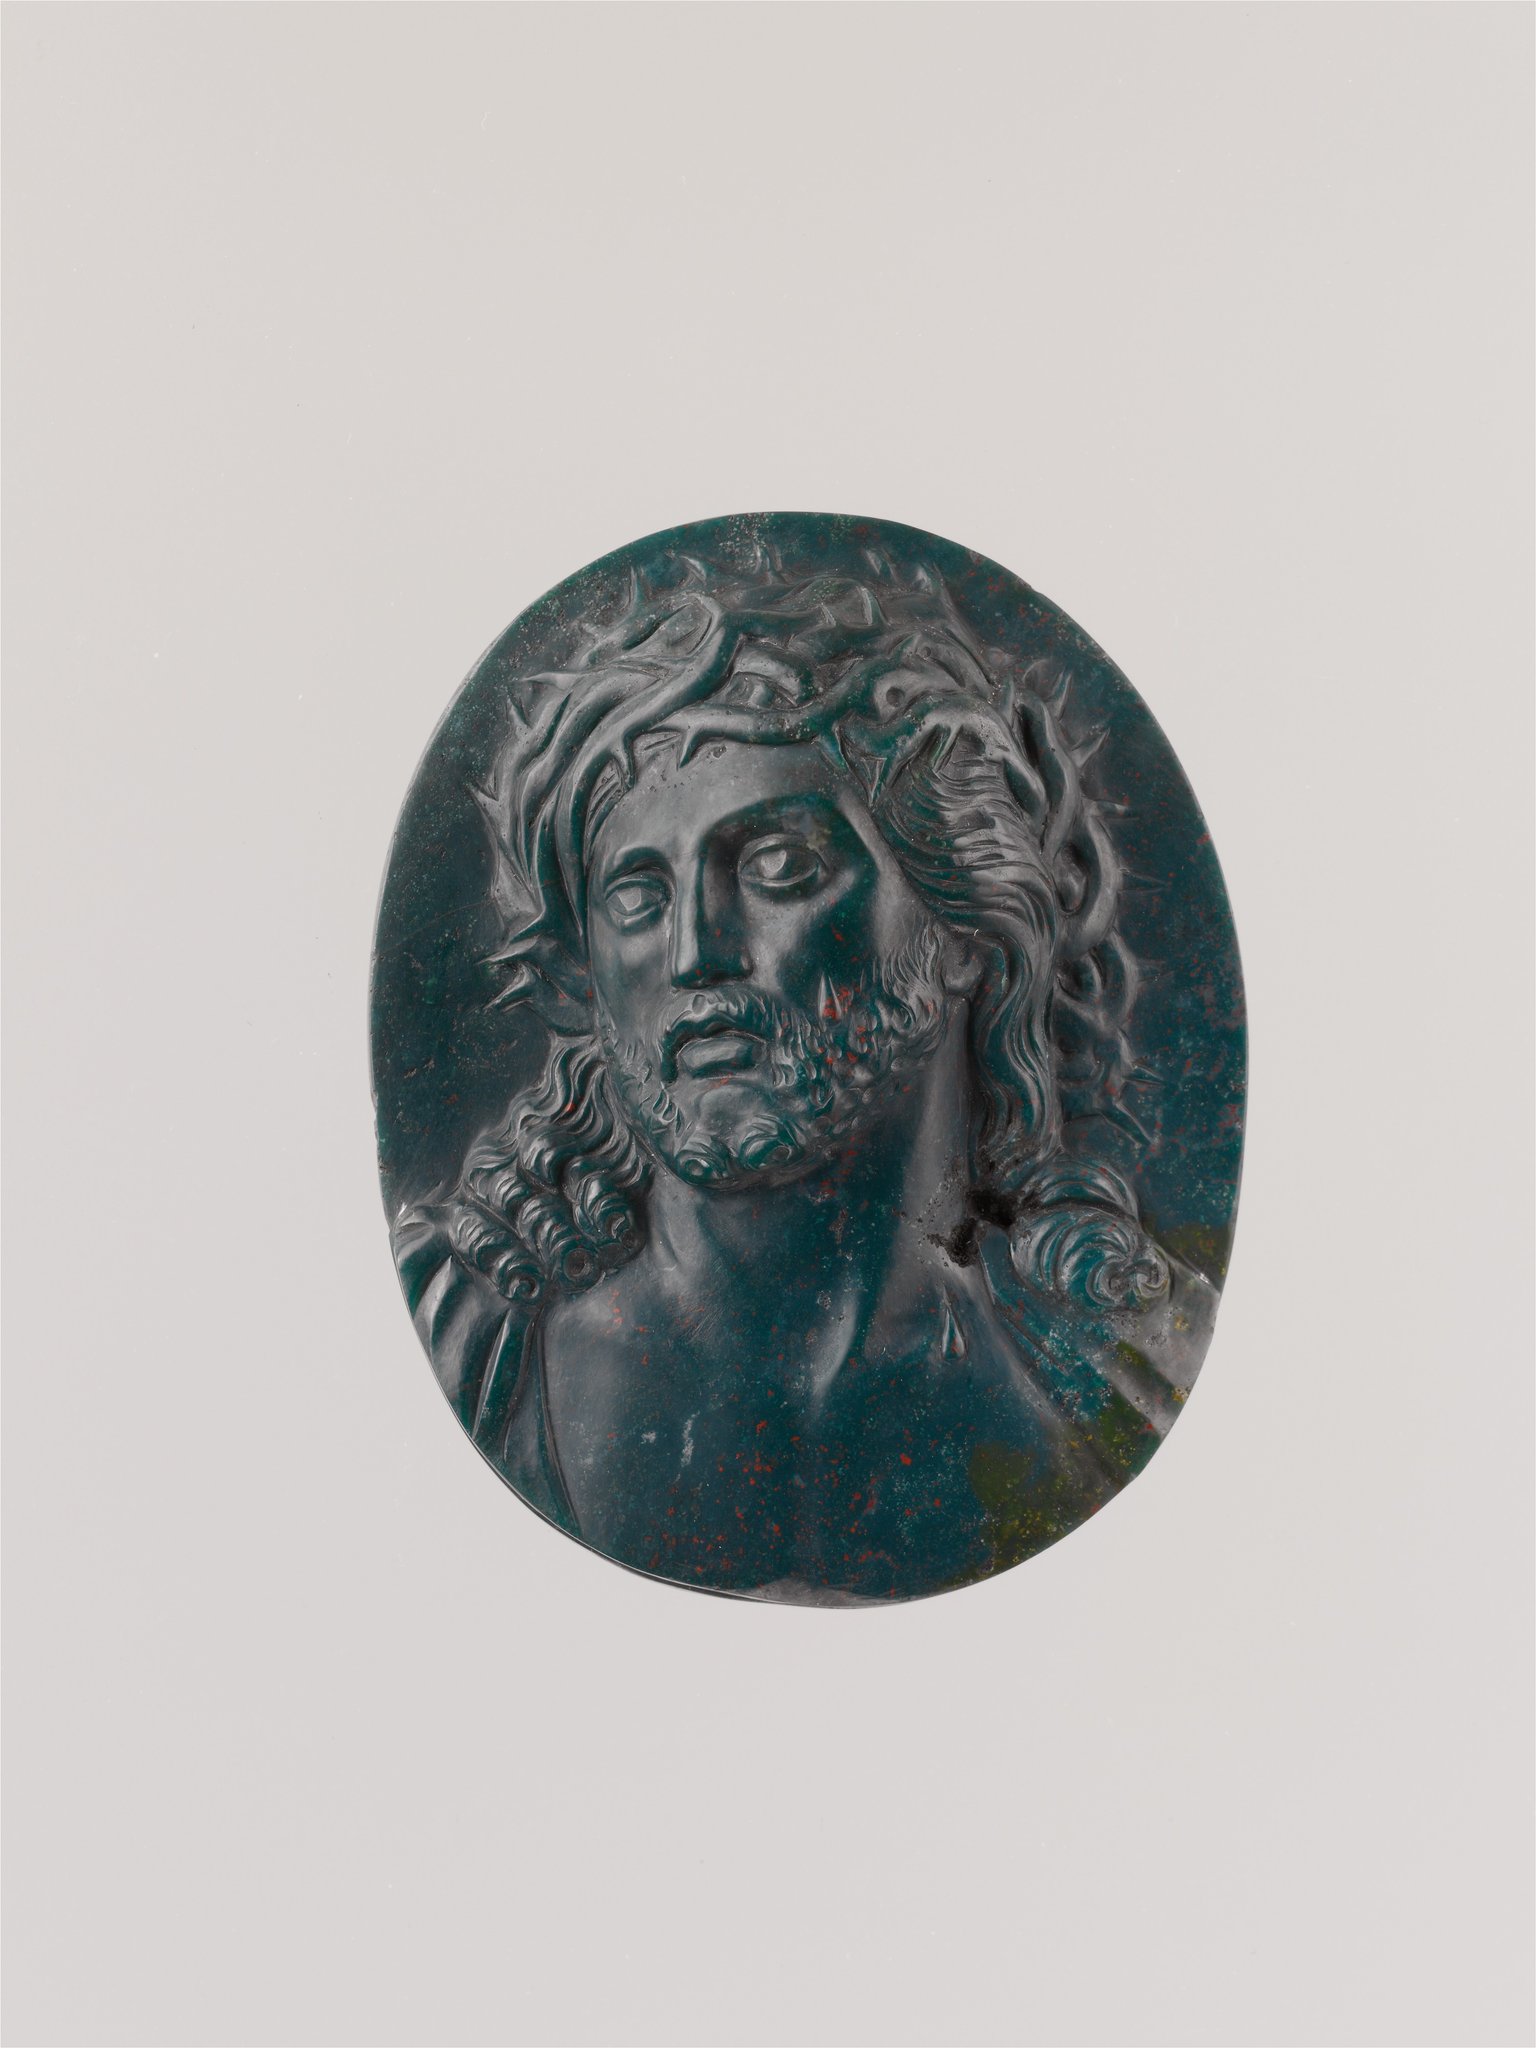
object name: cameo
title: Bust of Christ crowned with thorns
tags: christ